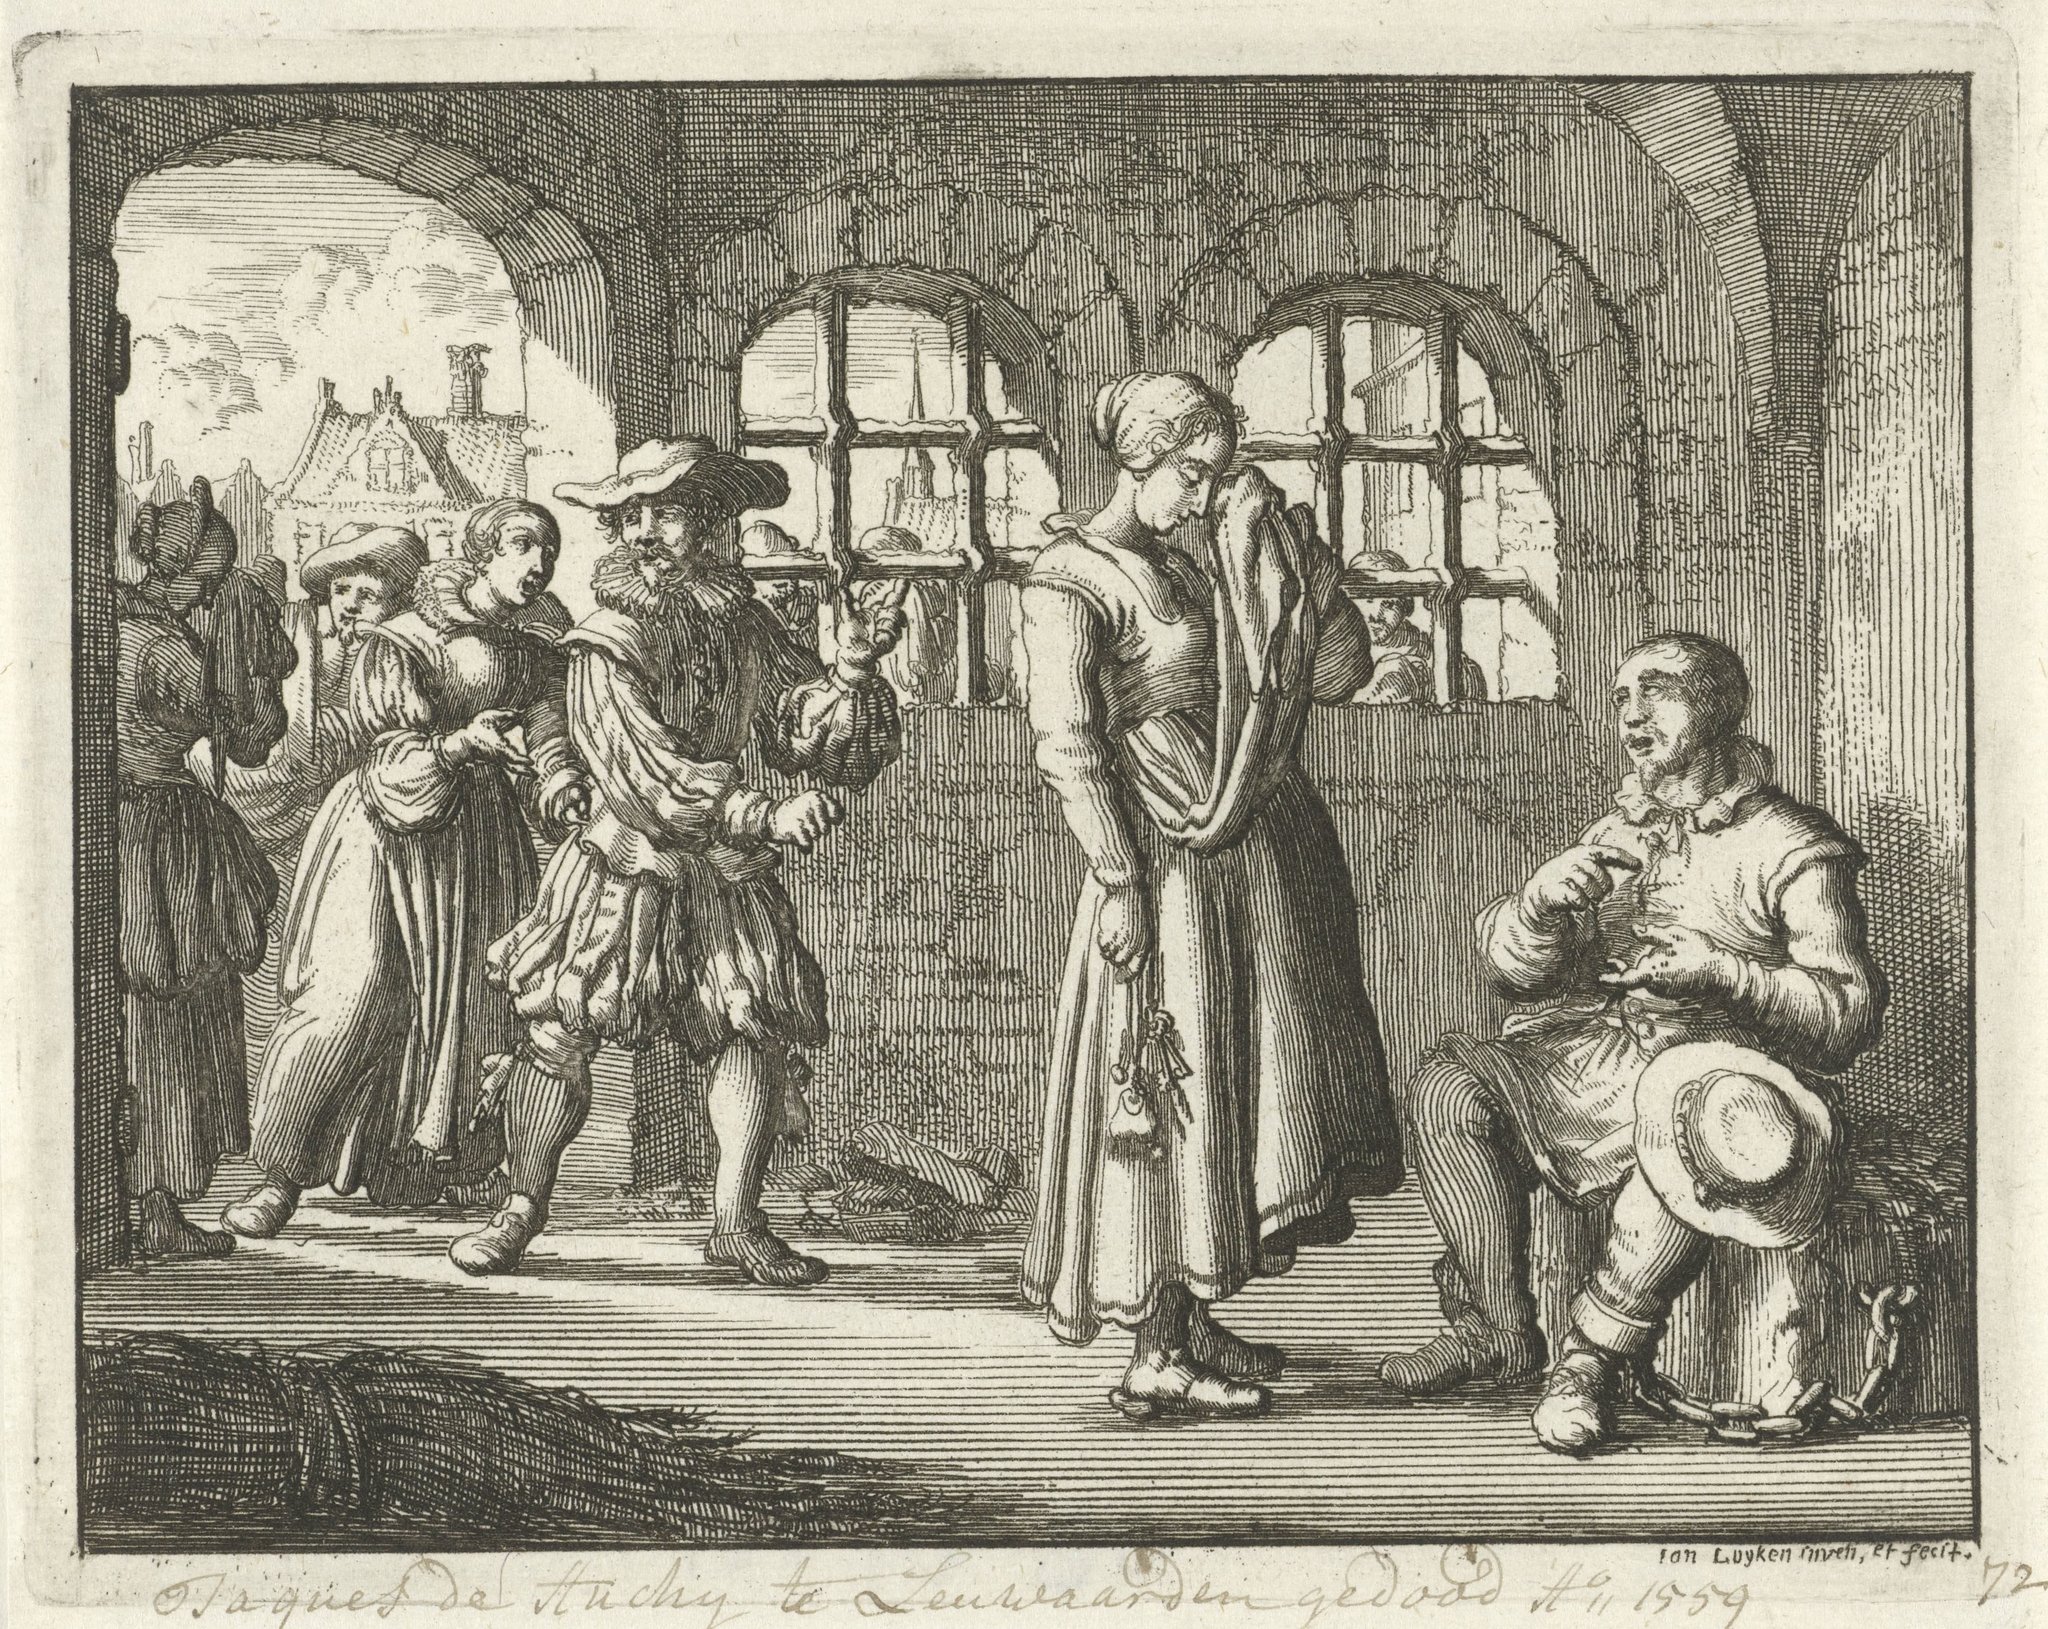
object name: book illustration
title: Jacques d'Auchy neemt in de gevangenis te Leeuwarden afscheid van zijn vrouw, 1558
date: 1685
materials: paper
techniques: etching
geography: amsterdam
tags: prison, jail, persecution of heretics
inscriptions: number: ‘72’, collector's mark: Lugt 2228, inscription: ‘Jaques de'Auchy [...] Ao 1559’